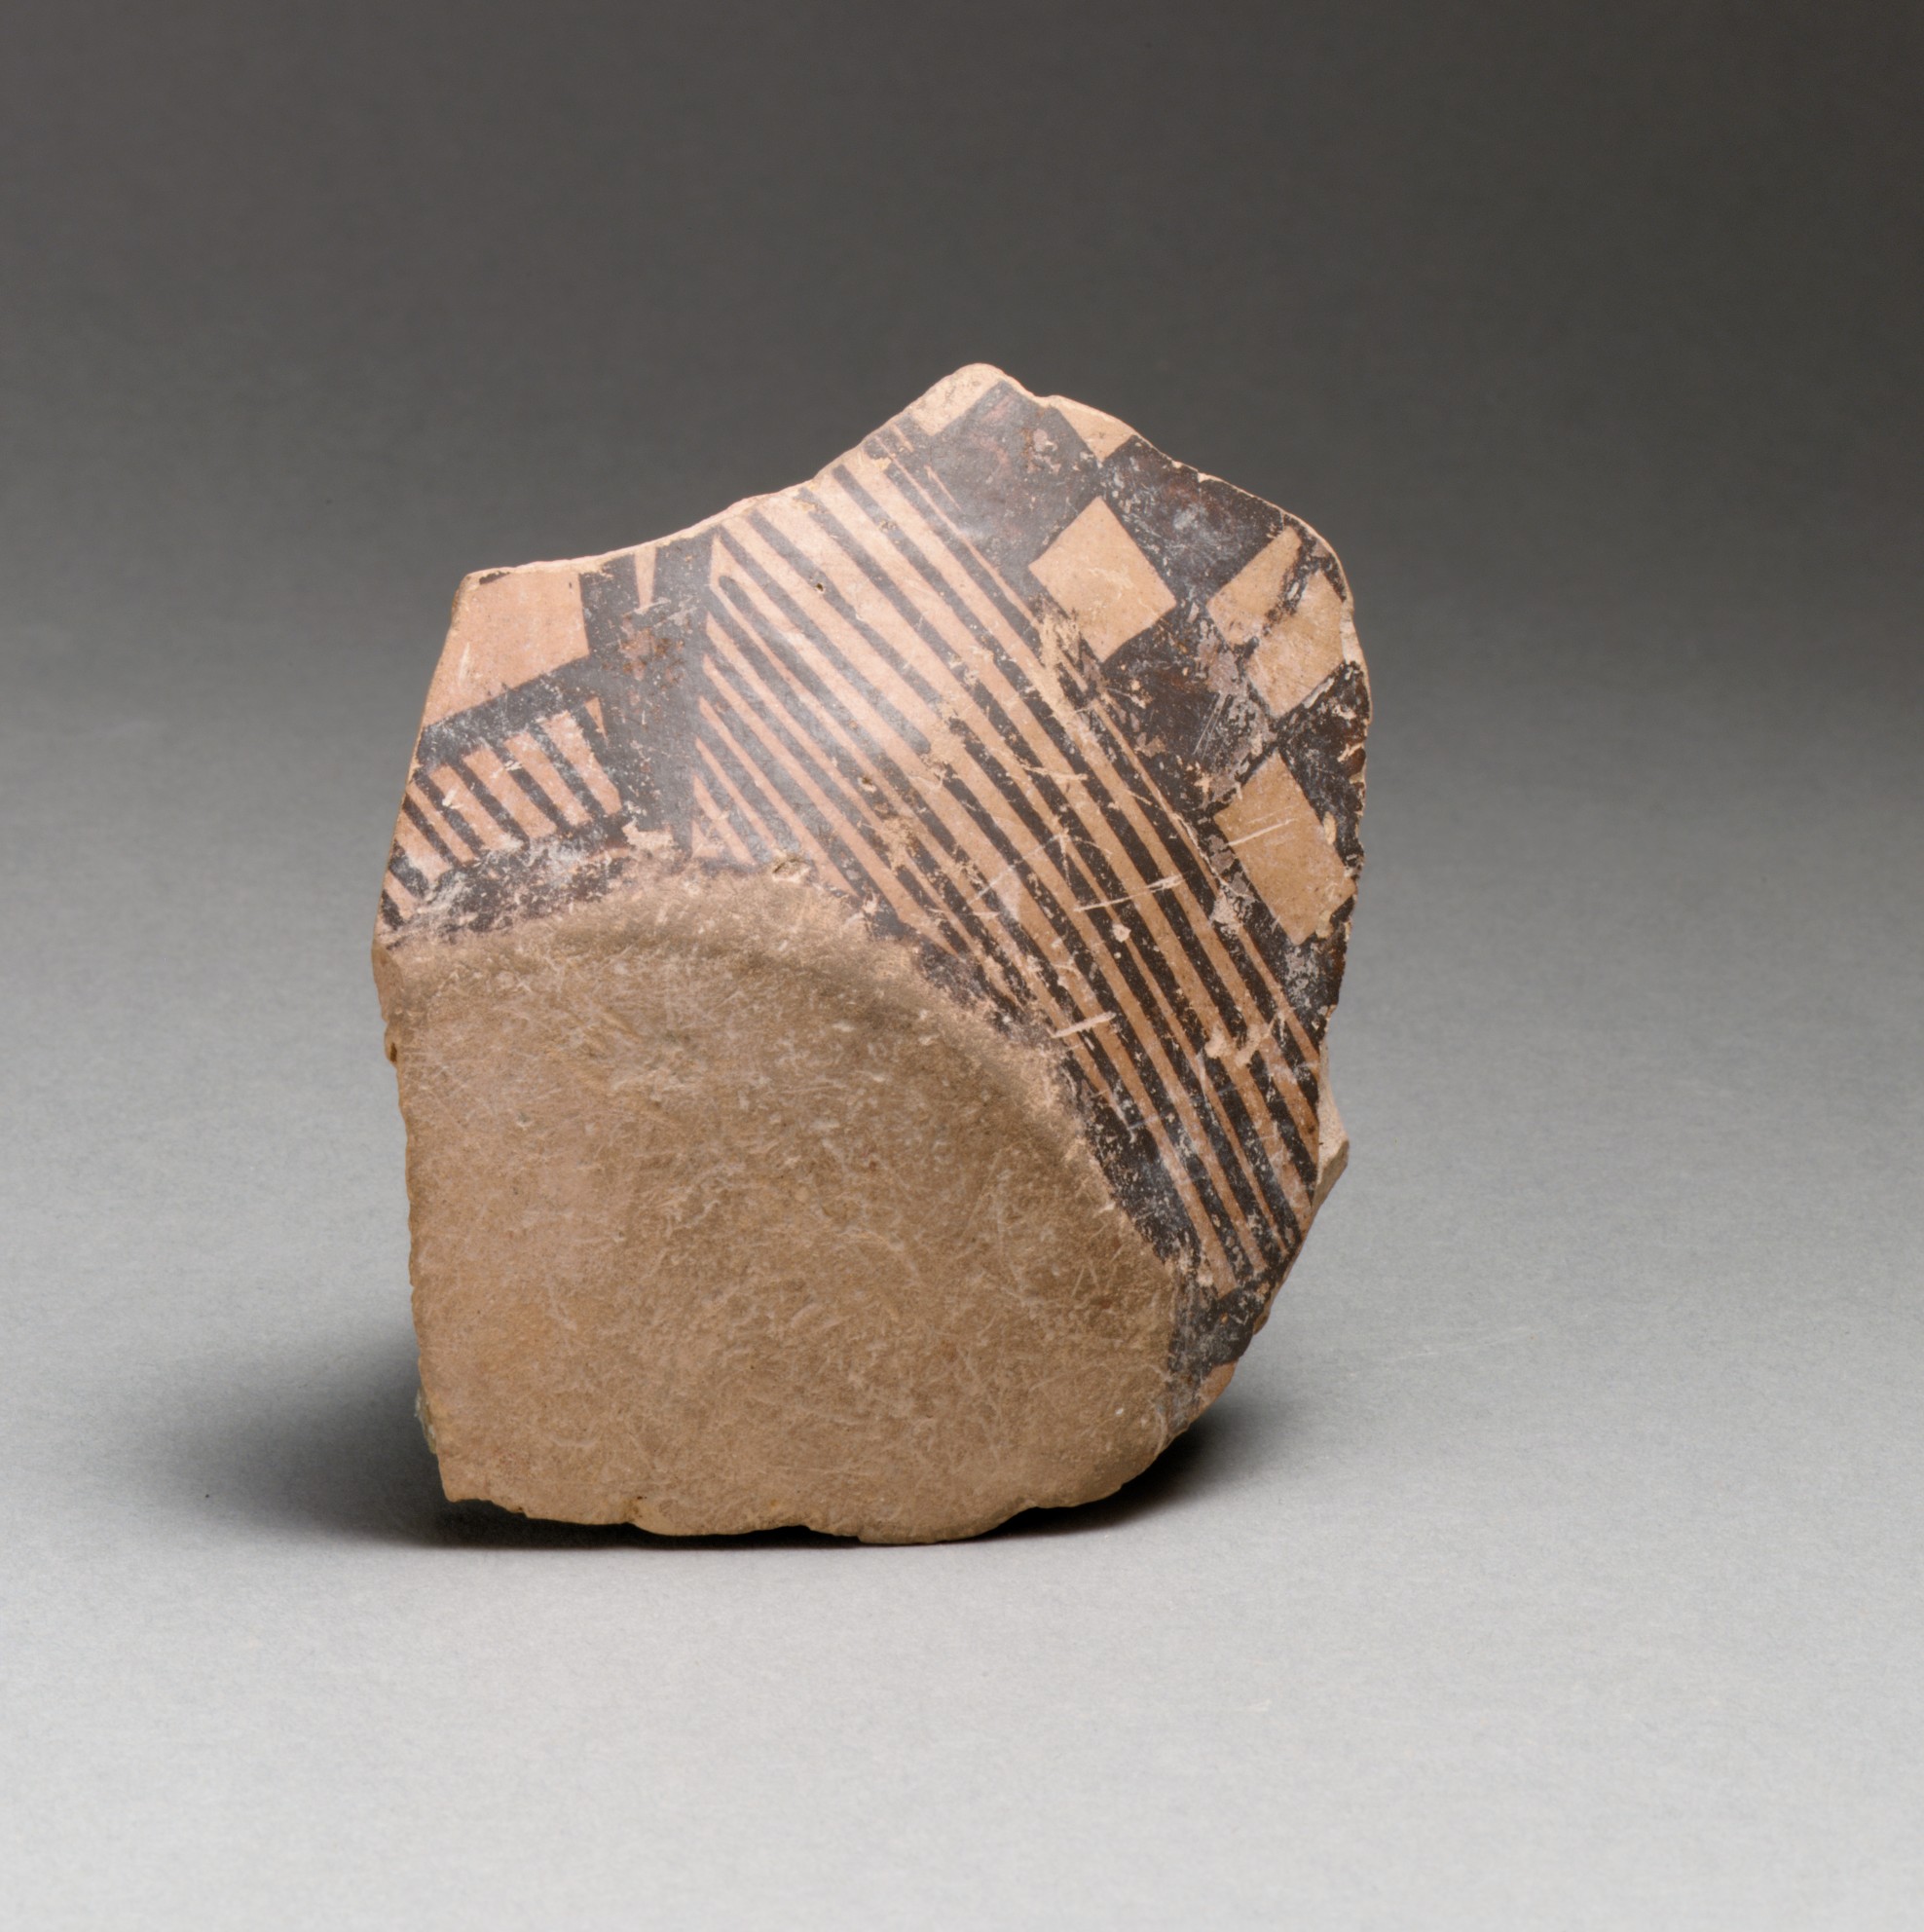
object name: vase fragment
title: Terracotta base and lower body of a vessel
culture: dimini culture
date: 3800-3300 BCE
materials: terracotta